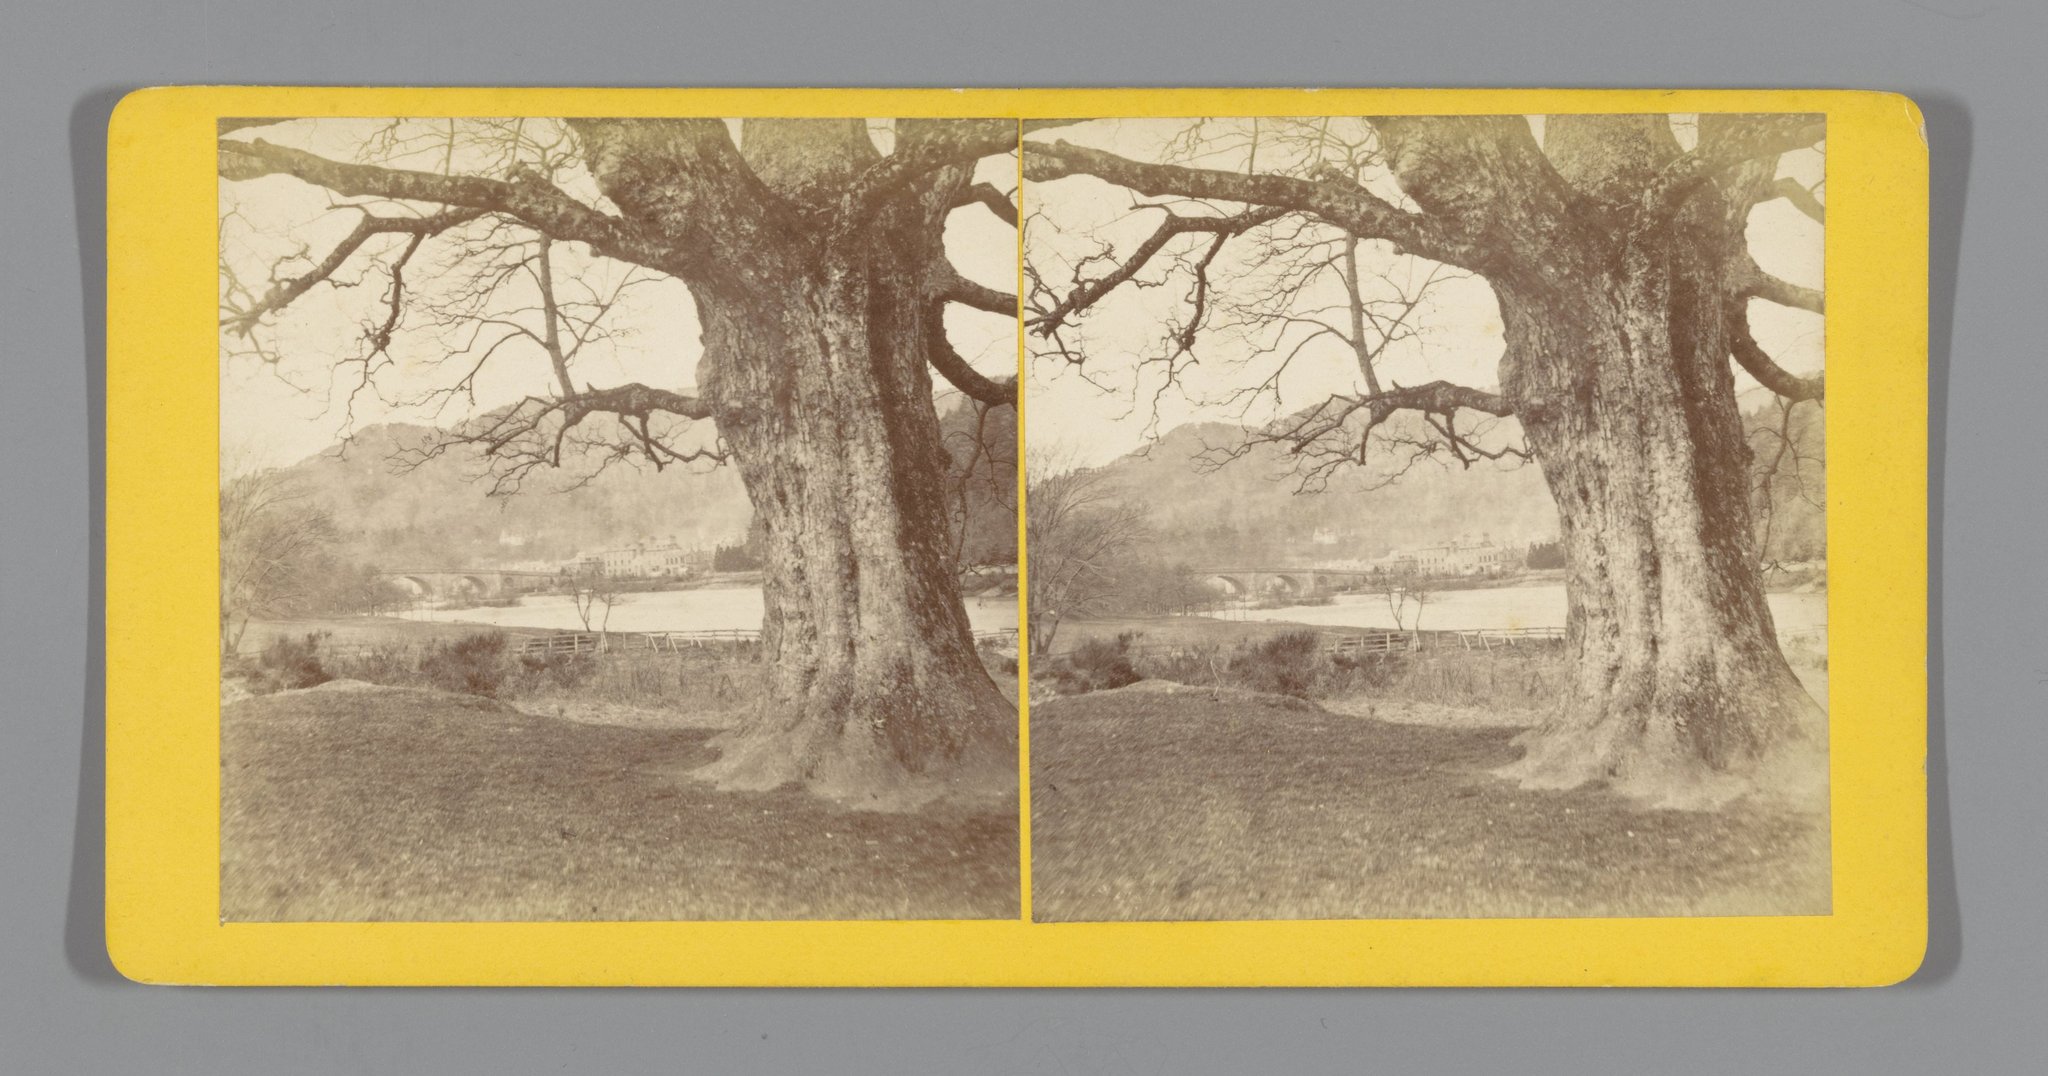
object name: stereograph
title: Gezicht op Dunkeld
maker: james valentine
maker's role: fotograaf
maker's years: 1815-1880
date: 1850-1880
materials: cardboard, photographic support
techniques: albumen print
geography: perth and kinross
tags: trees, city-view in general; 'veduta'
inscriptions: number: ‘9’, name: ‘J. Valentine, Dundee.’